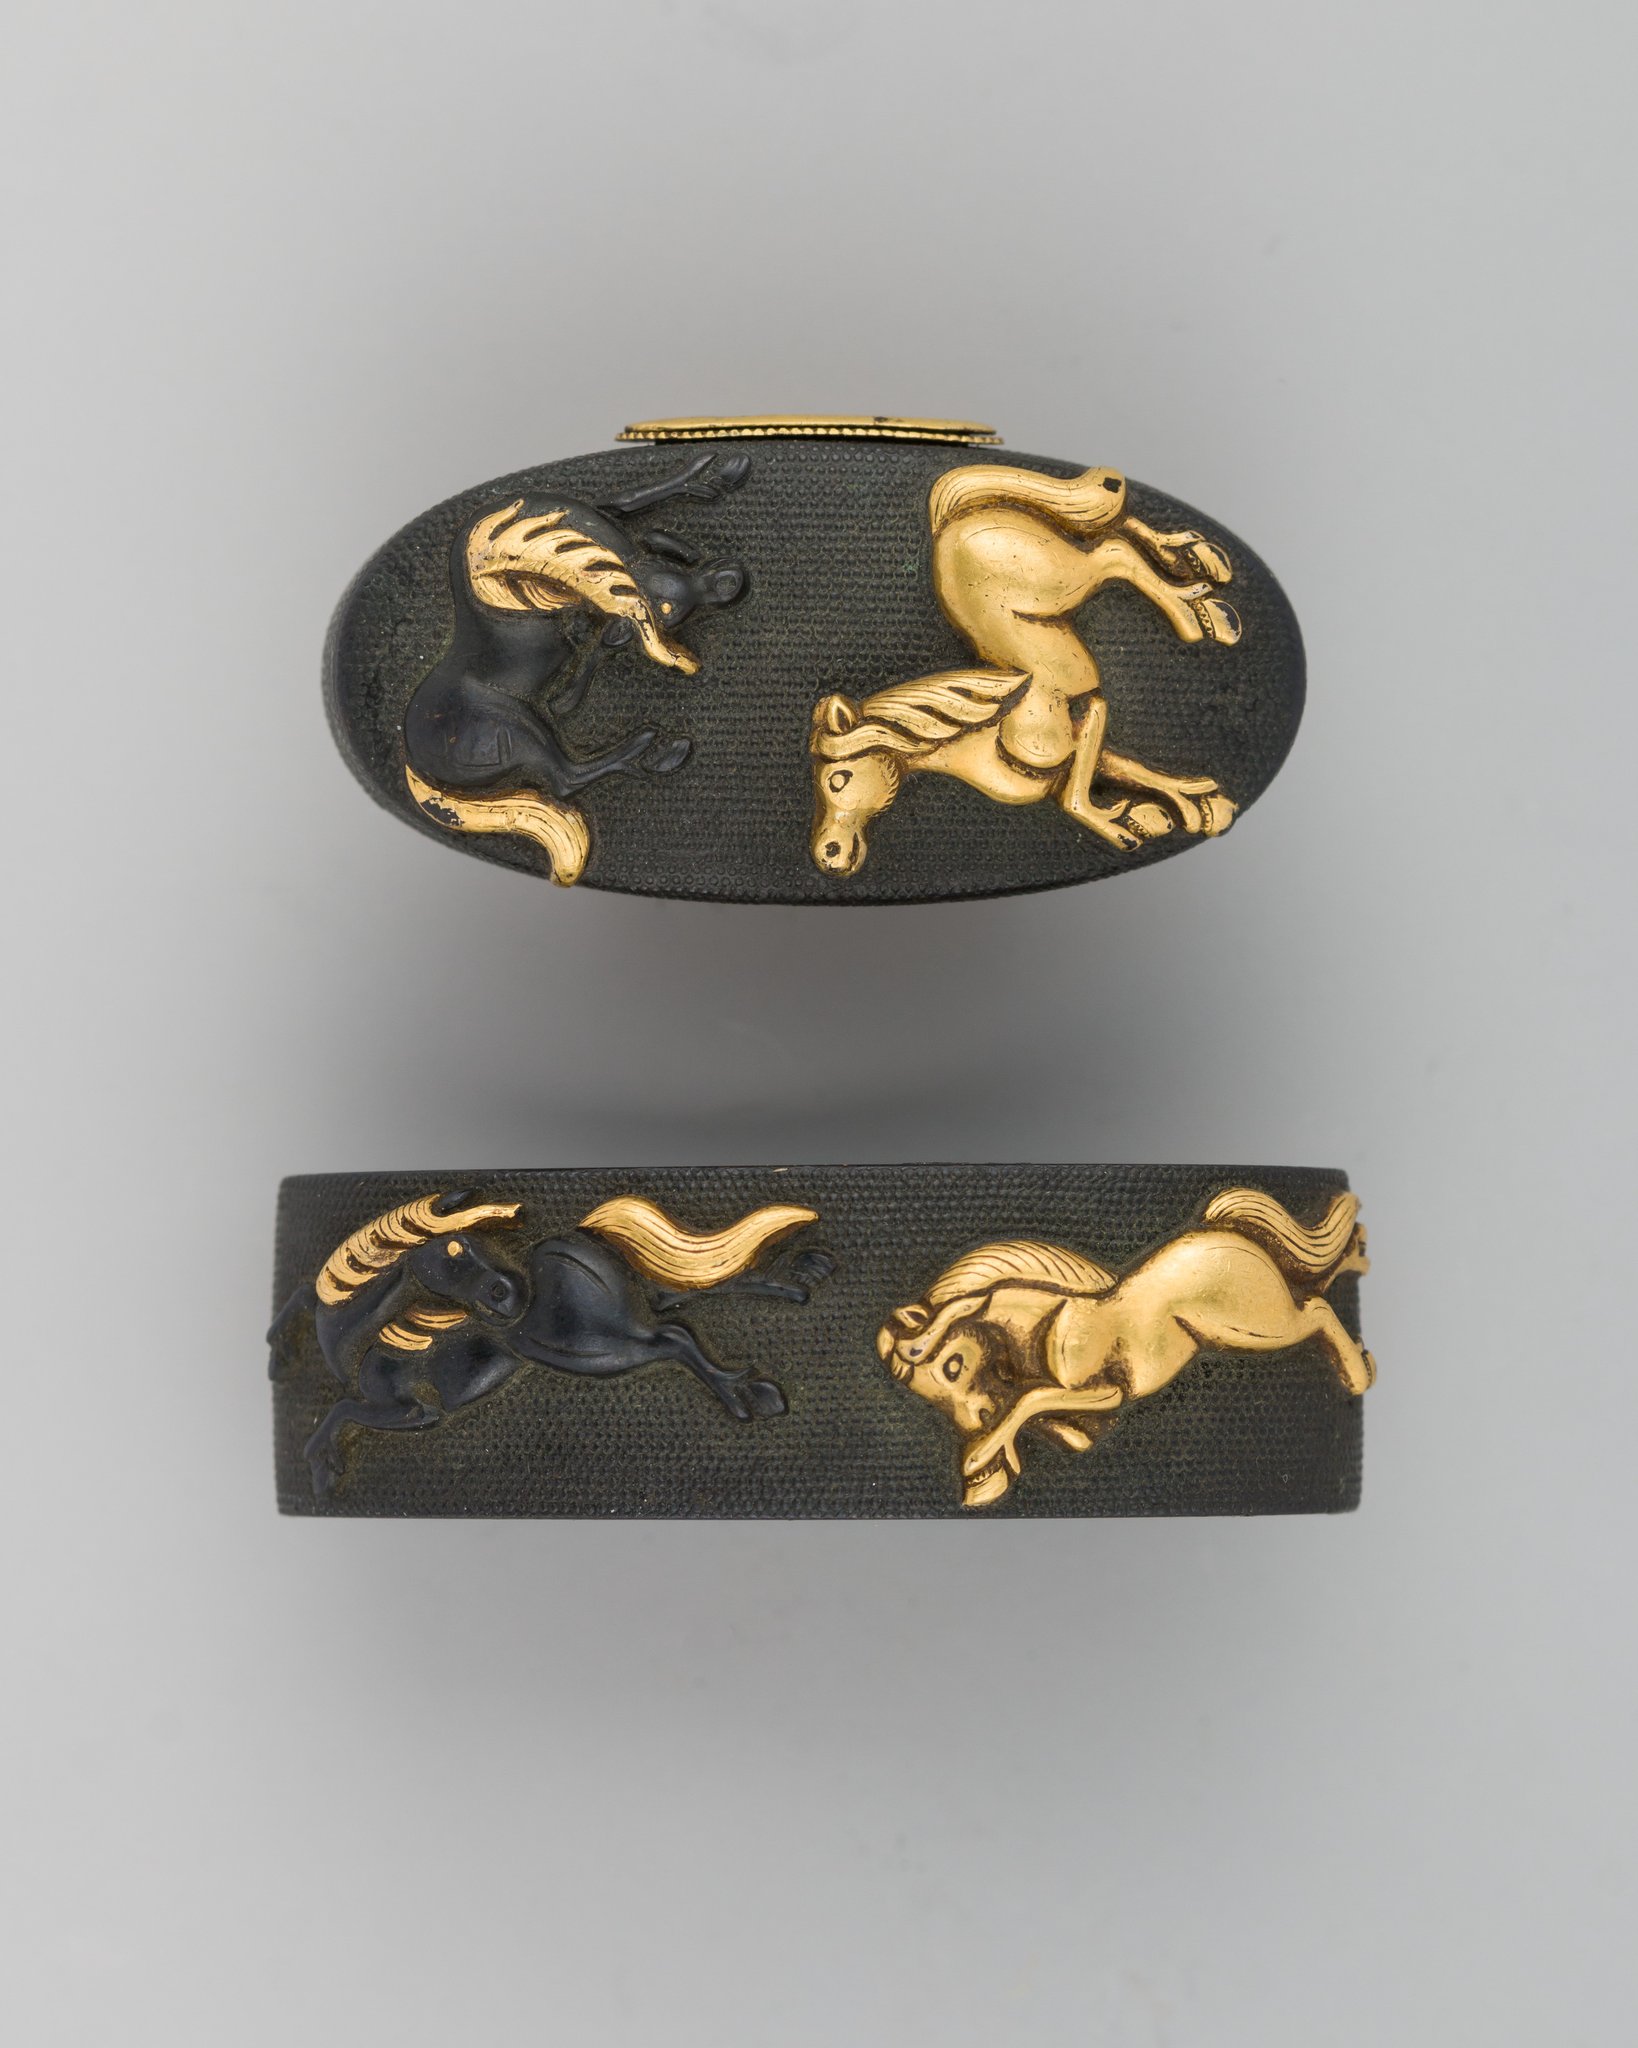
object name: sword hilt collar and pommel fuchigashira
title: Sword-Hilt Collar and Pommel (Fuchigashira)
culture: japanese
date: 1601-1700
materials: gold alloy, gold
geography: japan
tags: horses